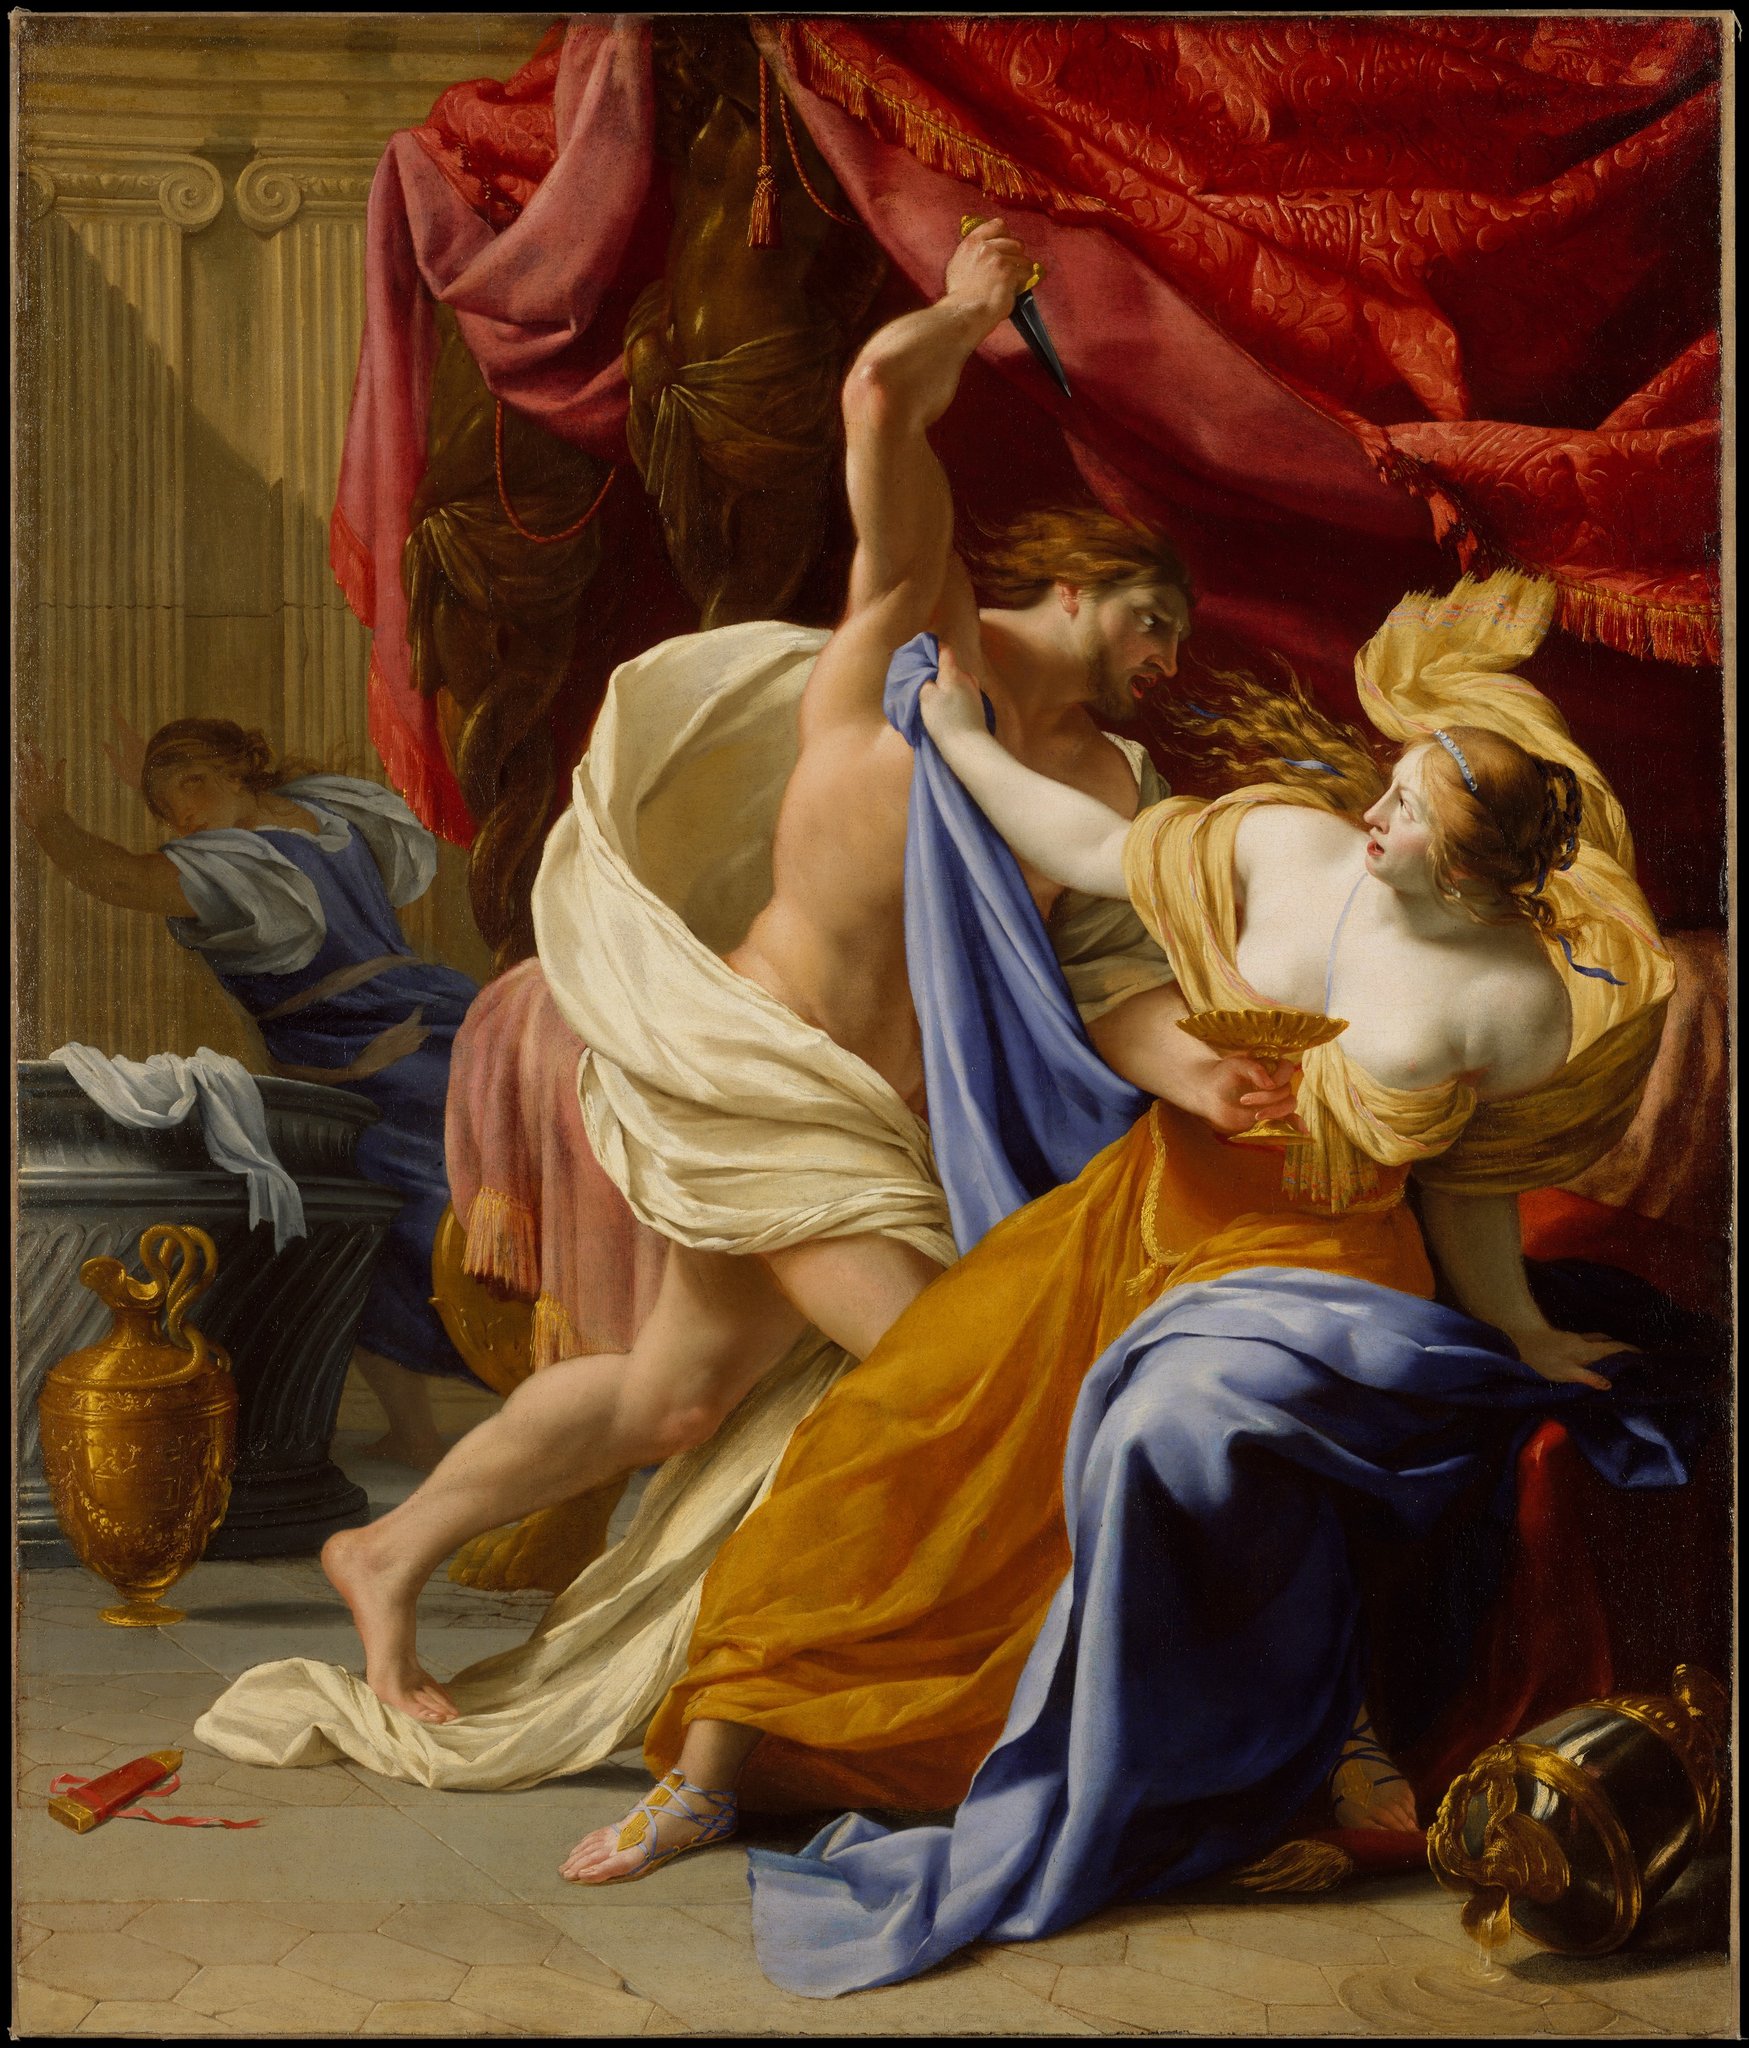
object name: painting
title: The Rape of Tamar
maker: eustache le sueur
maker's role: artist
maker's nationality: french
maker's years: 1616-1655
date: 1640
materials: canvas, oil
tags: bedrooms,men,women